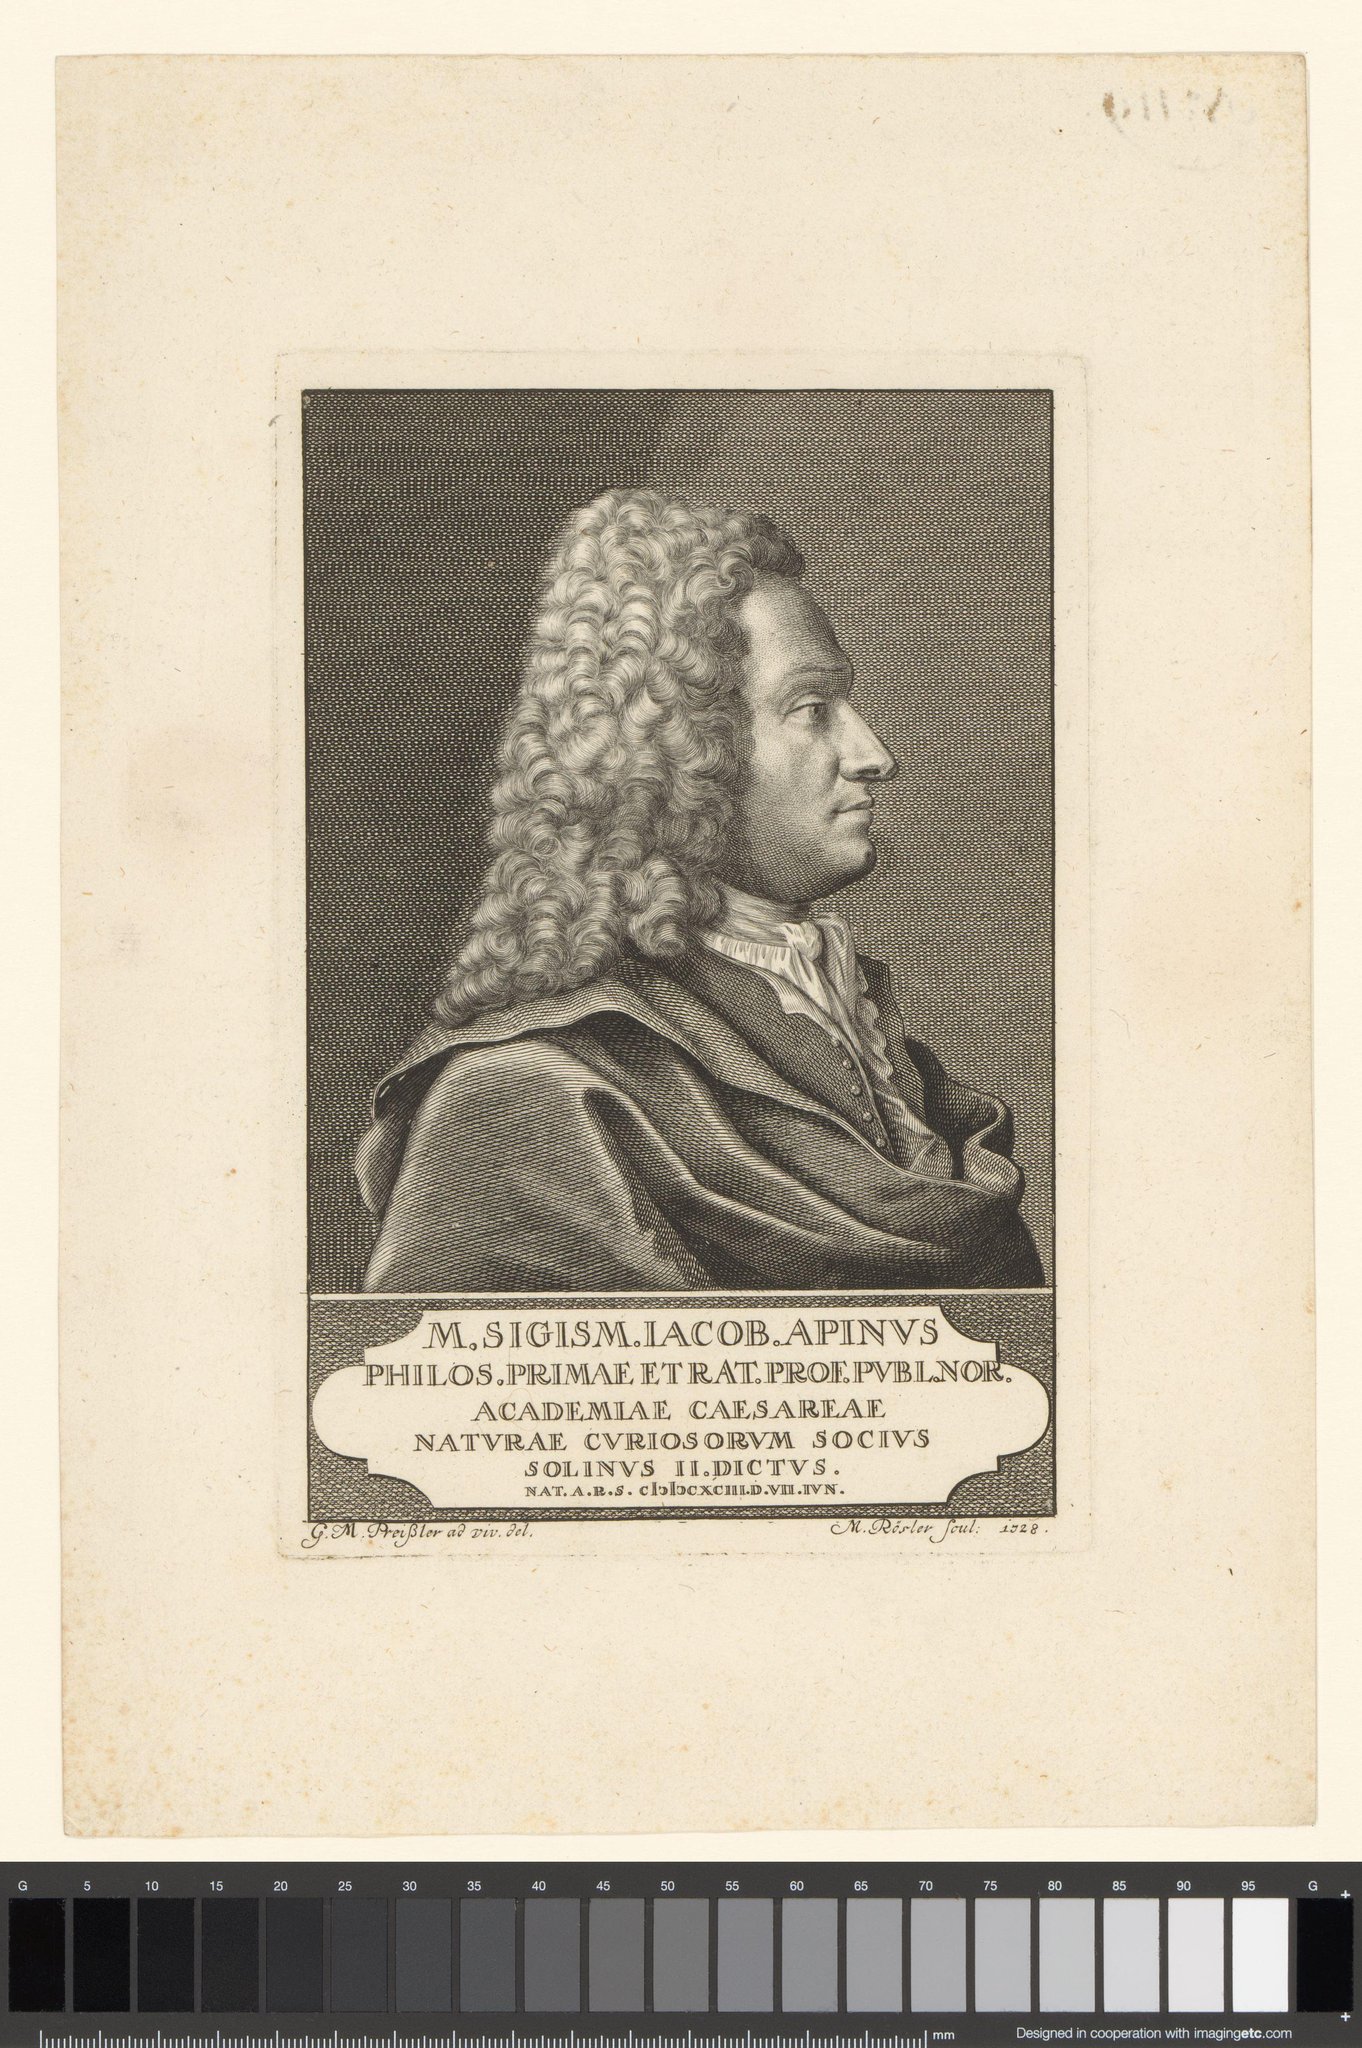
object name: print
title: Portret van Sigmund Jacob Apin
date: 1728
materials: paper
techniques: engraving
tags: sigmund jacob apin, historical persons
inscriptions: collector's mark: Lugt 2228